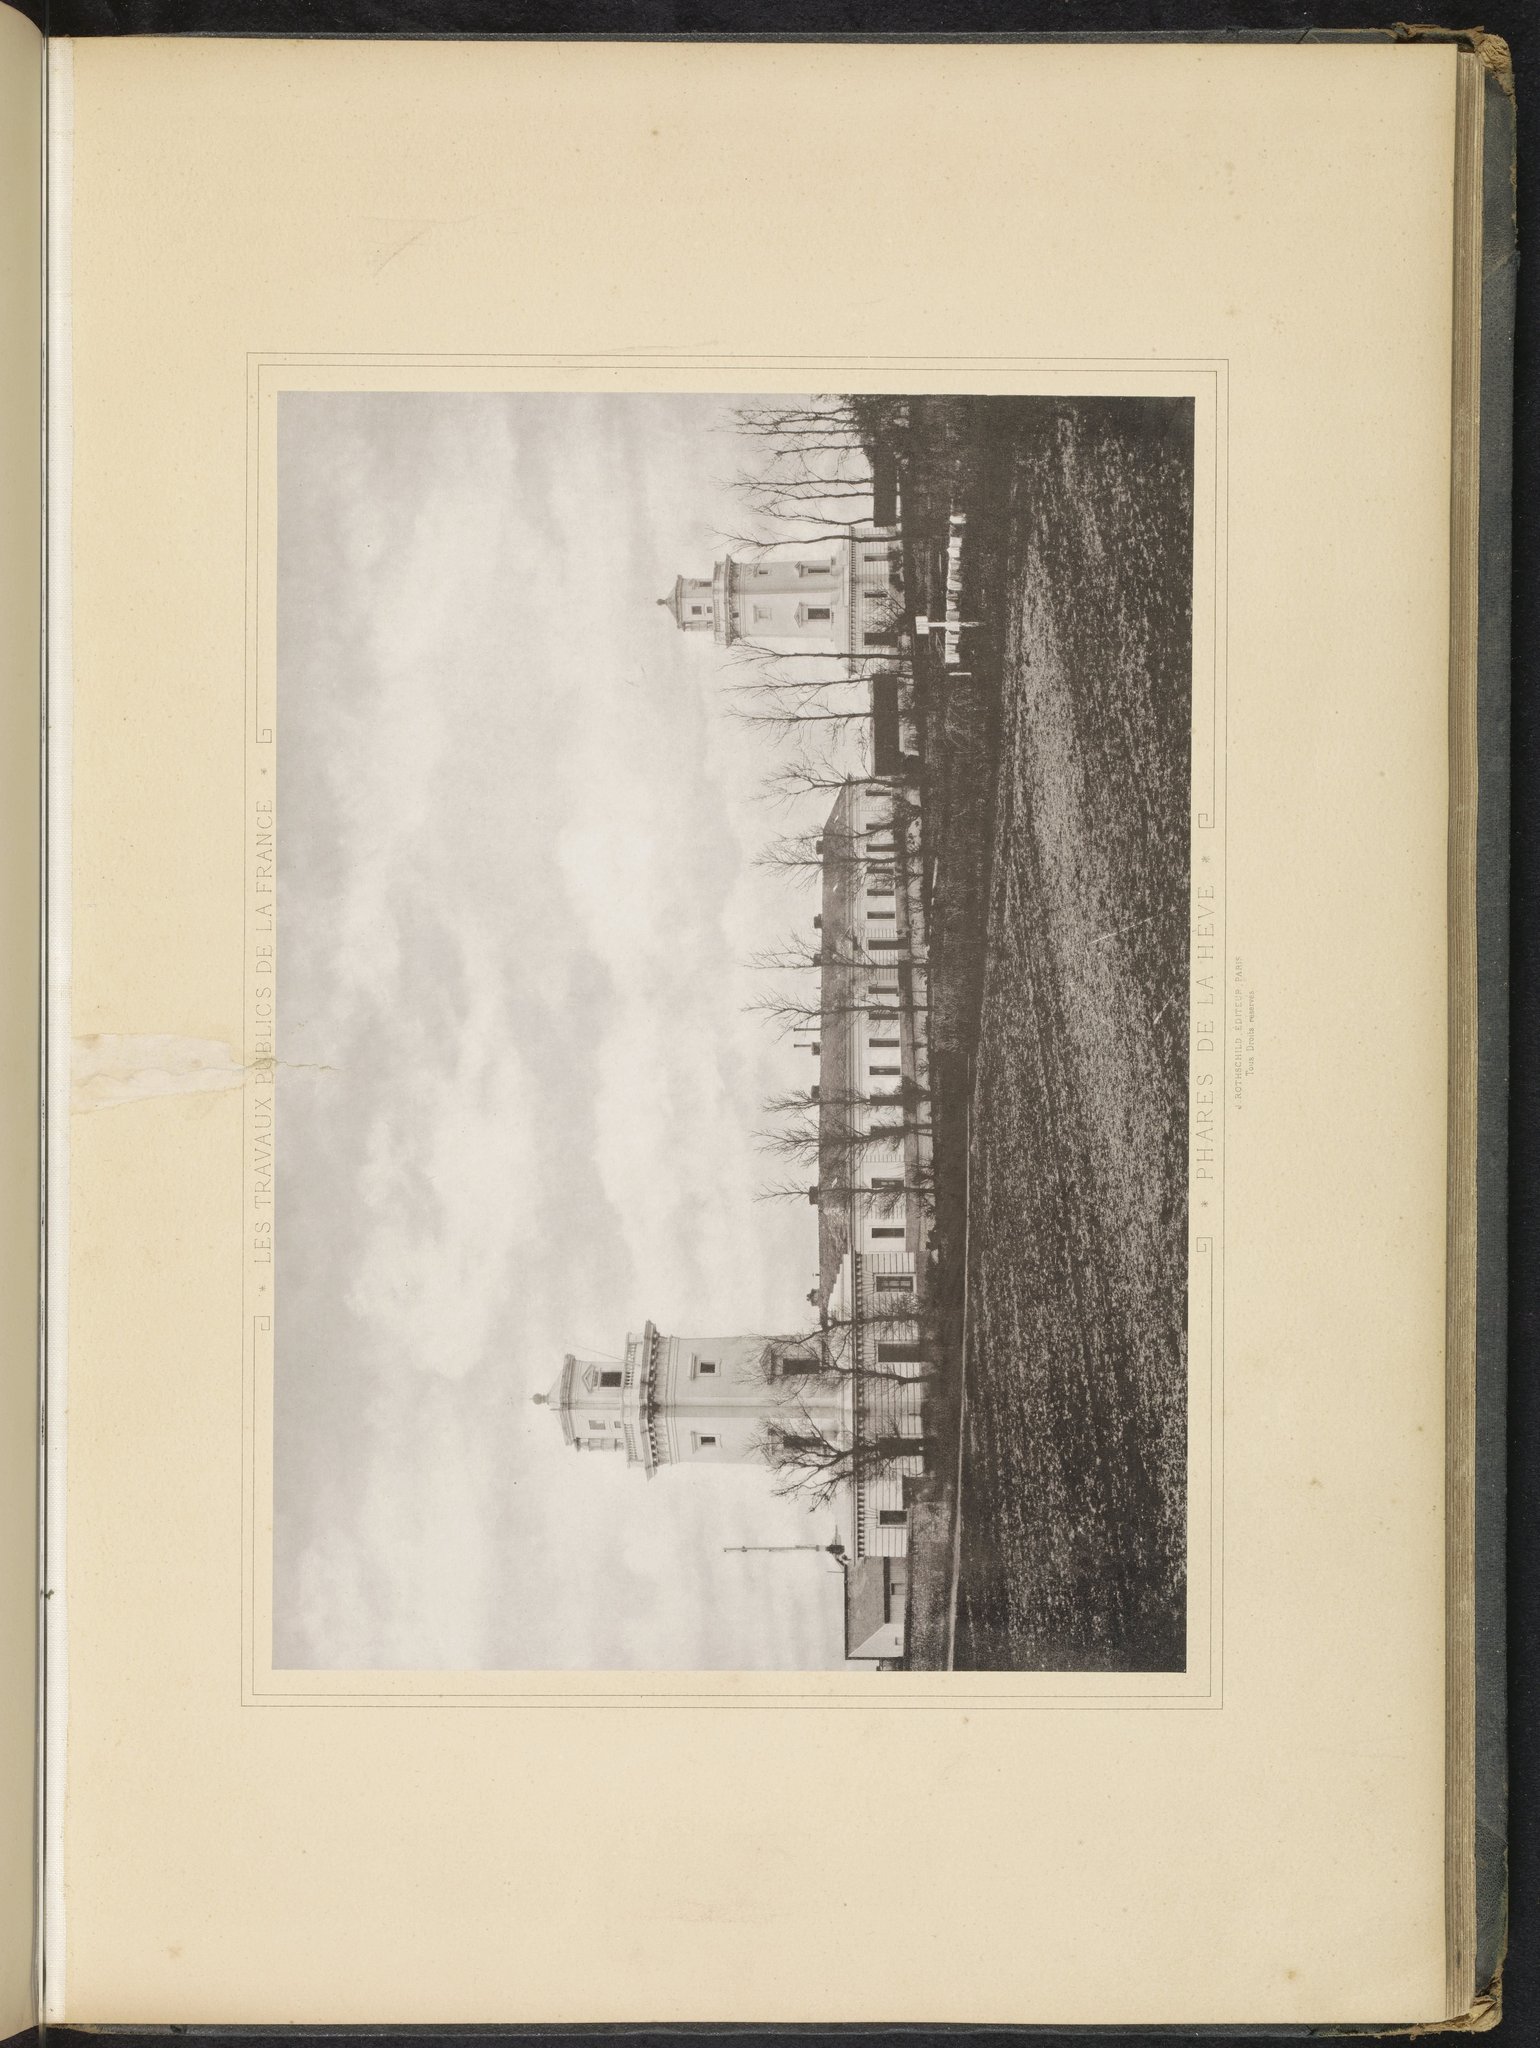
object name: photomechanical print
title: Vuurtorens van La Hève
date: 1873-1883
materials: paper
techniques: photograph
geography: france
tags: lighthouse, lightship